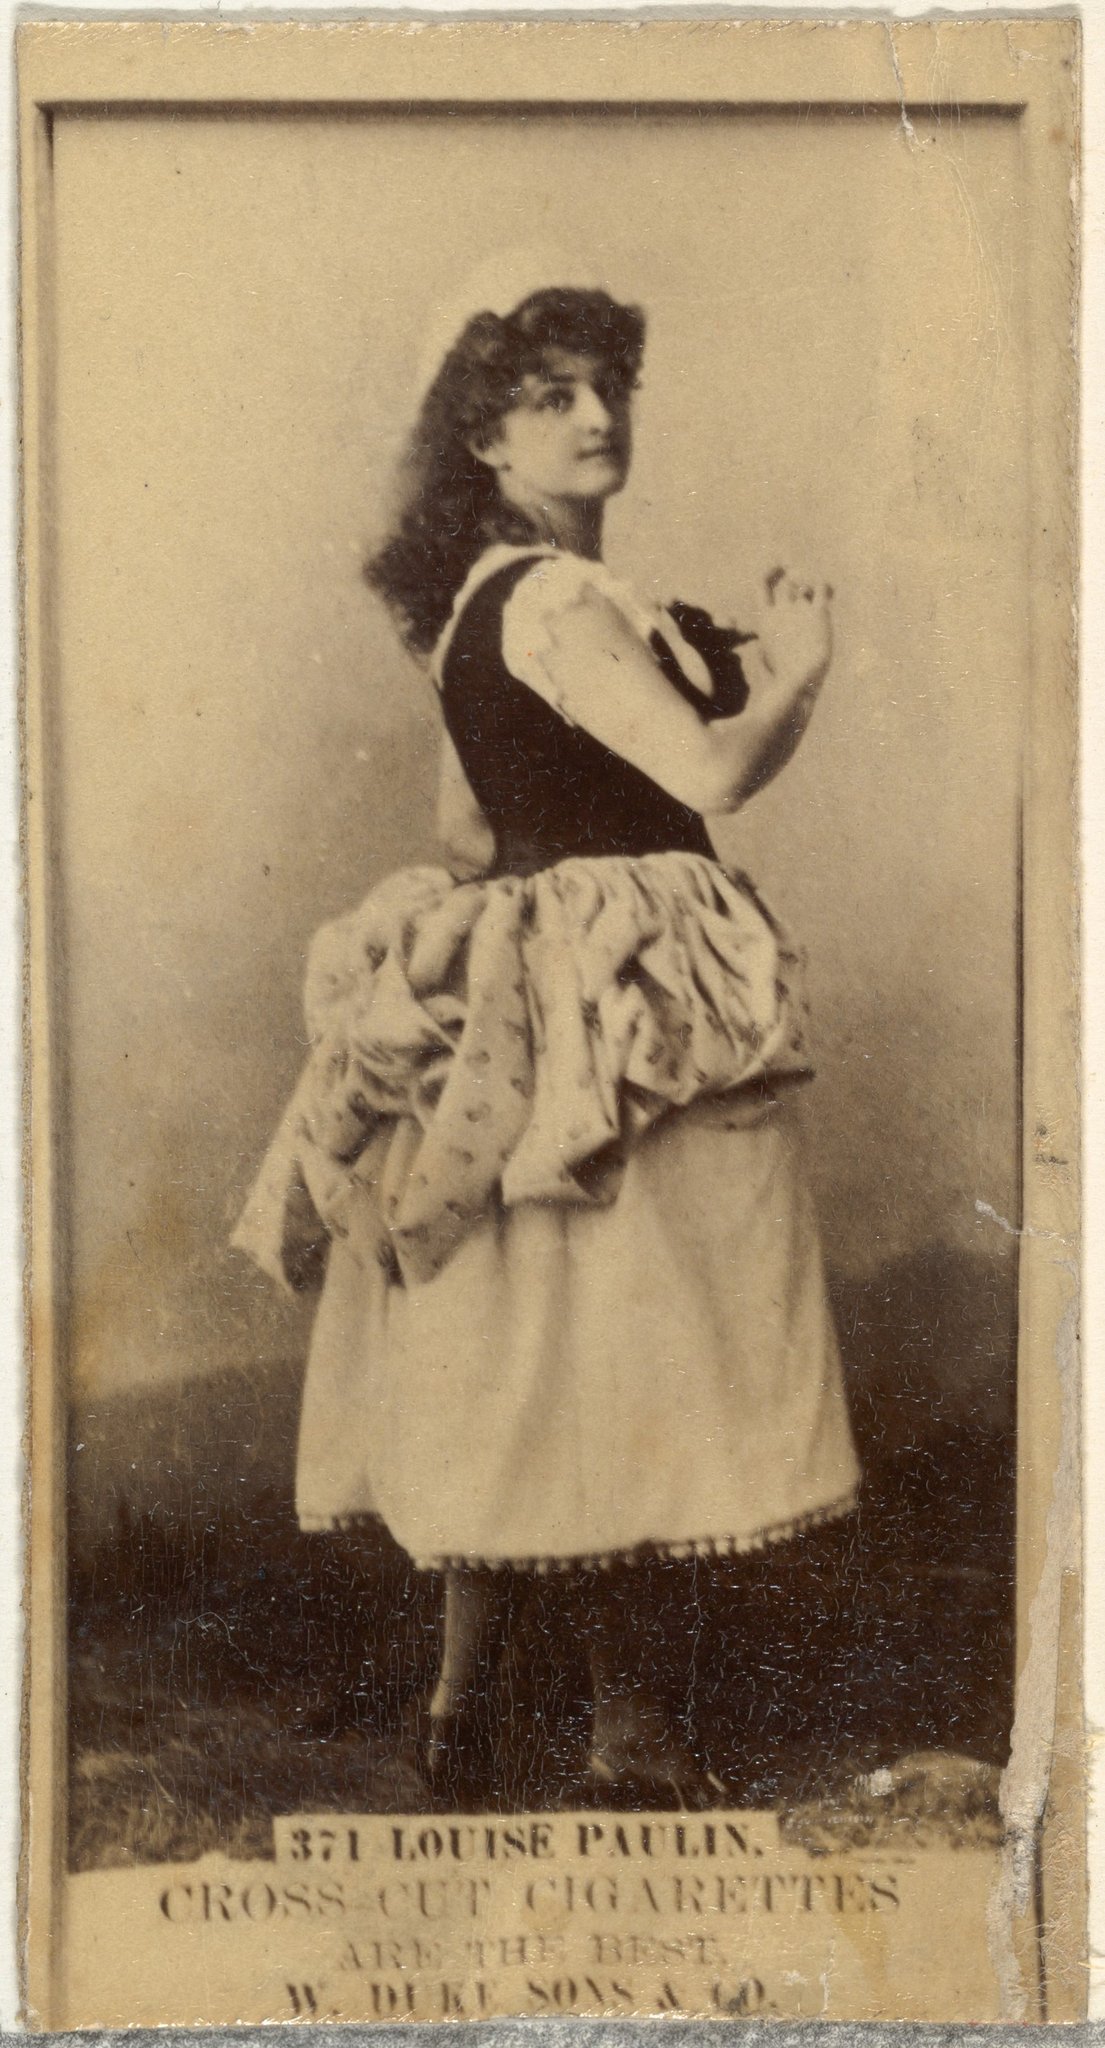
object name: photograph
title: Card Number 371, Louise Paullin, from the Actors and Actresses series (N145-3) issued by Duke Sons & Co. to promote Cross Cut Cigarettes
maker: w. duke, sons & co.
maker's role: publisher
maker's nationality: american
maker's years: 1870-1920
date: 1880-1889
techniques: albumen silver print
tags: portraits,women,actresses